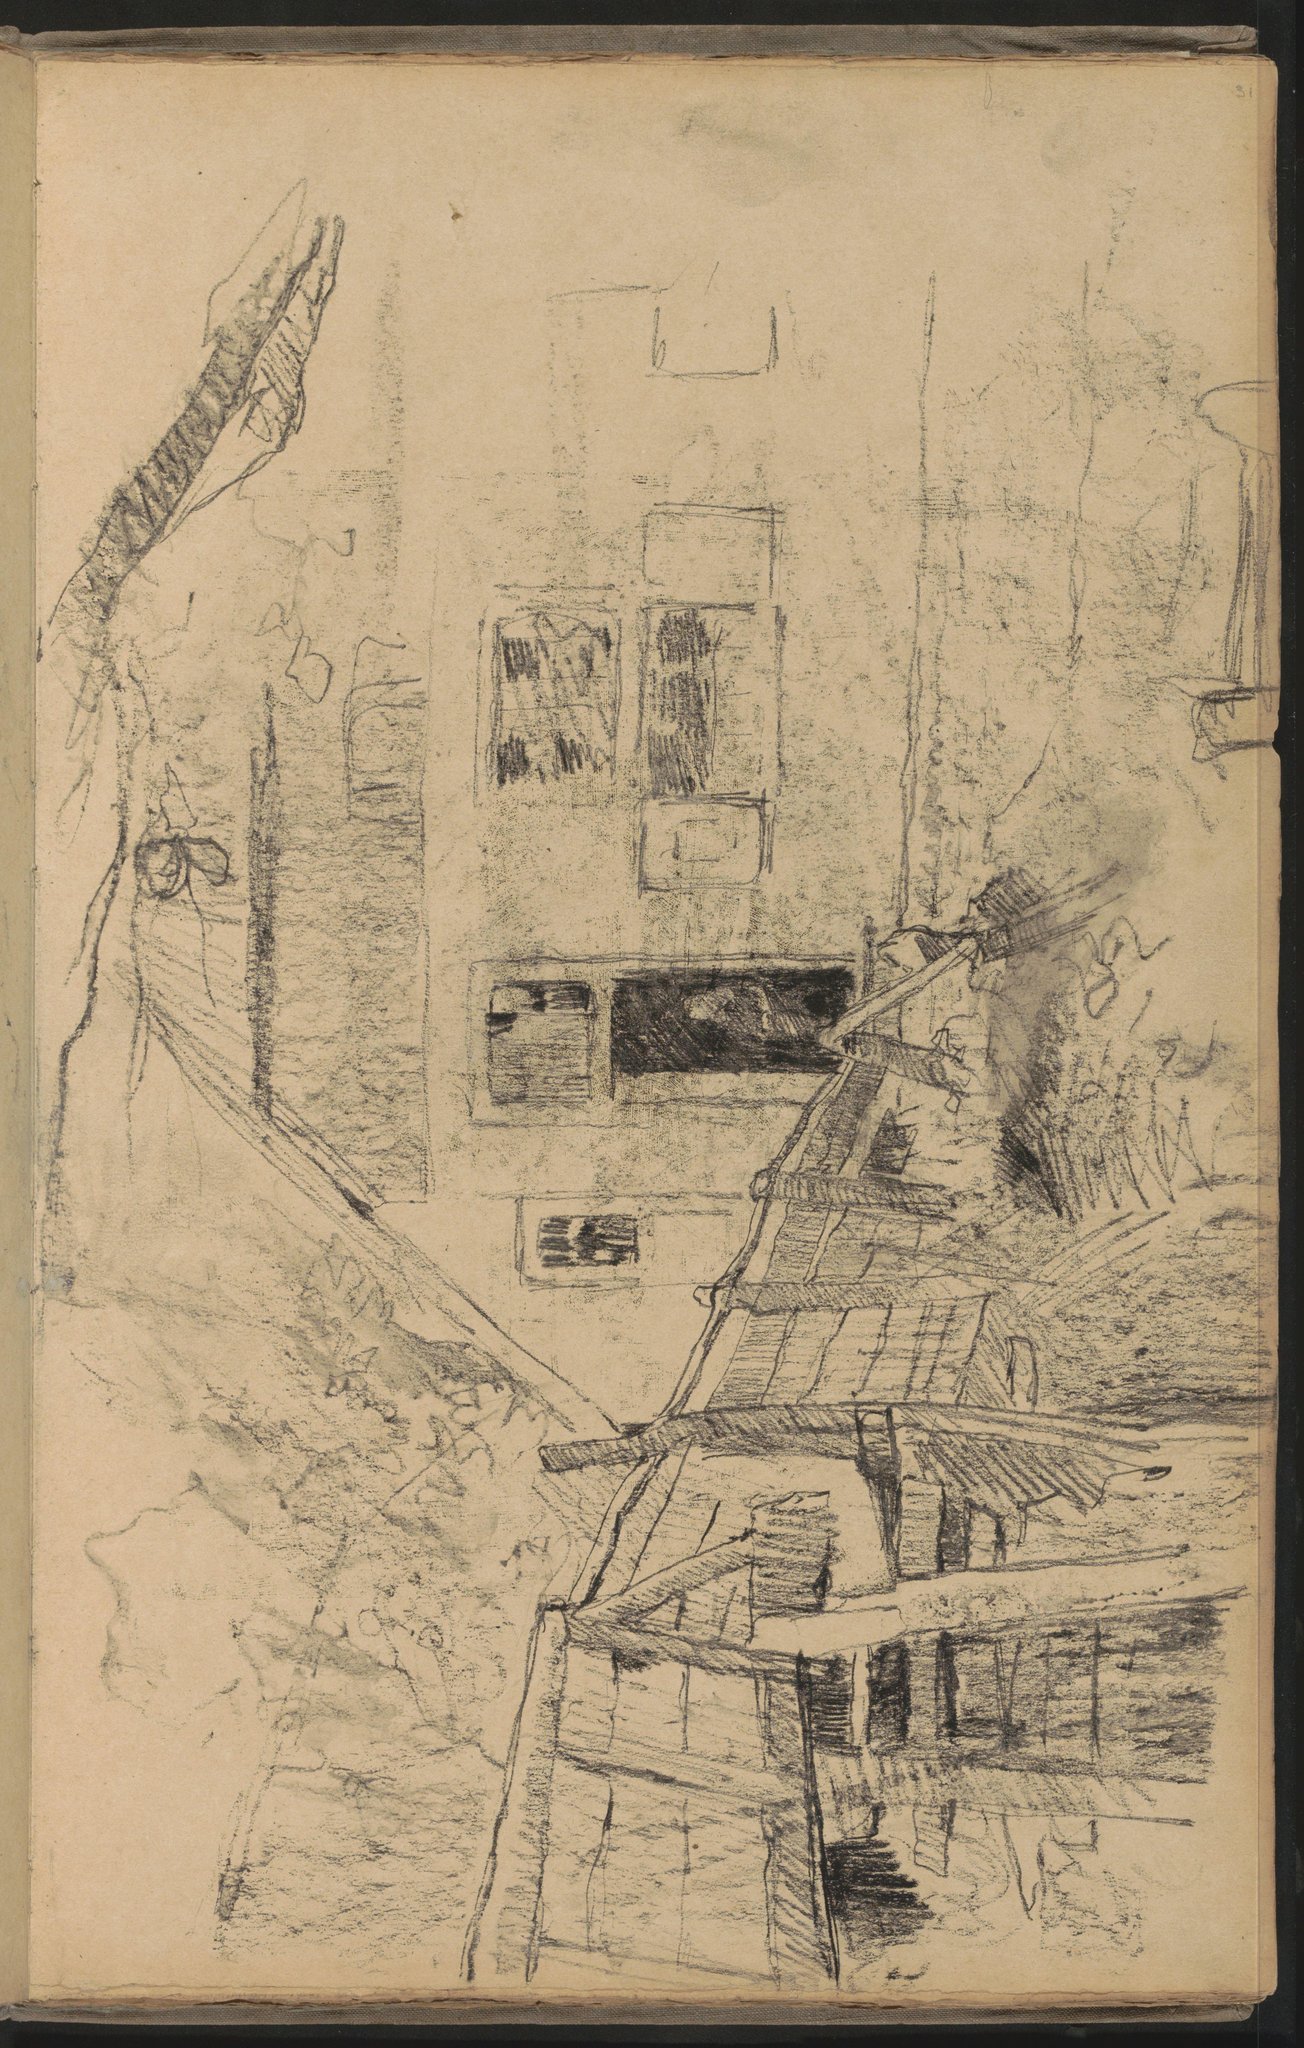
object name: sketchbook leaf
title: Boerderij bij een brug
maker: willem witsen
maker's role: draughtsman, painter, print maker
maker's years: 1860-1923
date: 1884-1887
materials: chalk, paper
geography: ewijkshoeve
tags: bridge, farm (building)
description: In de deuropening staat een figuur. Pagina 31 uit een schetsboek met 42 bladen vervaardigd rond de Ewijkshoeve.